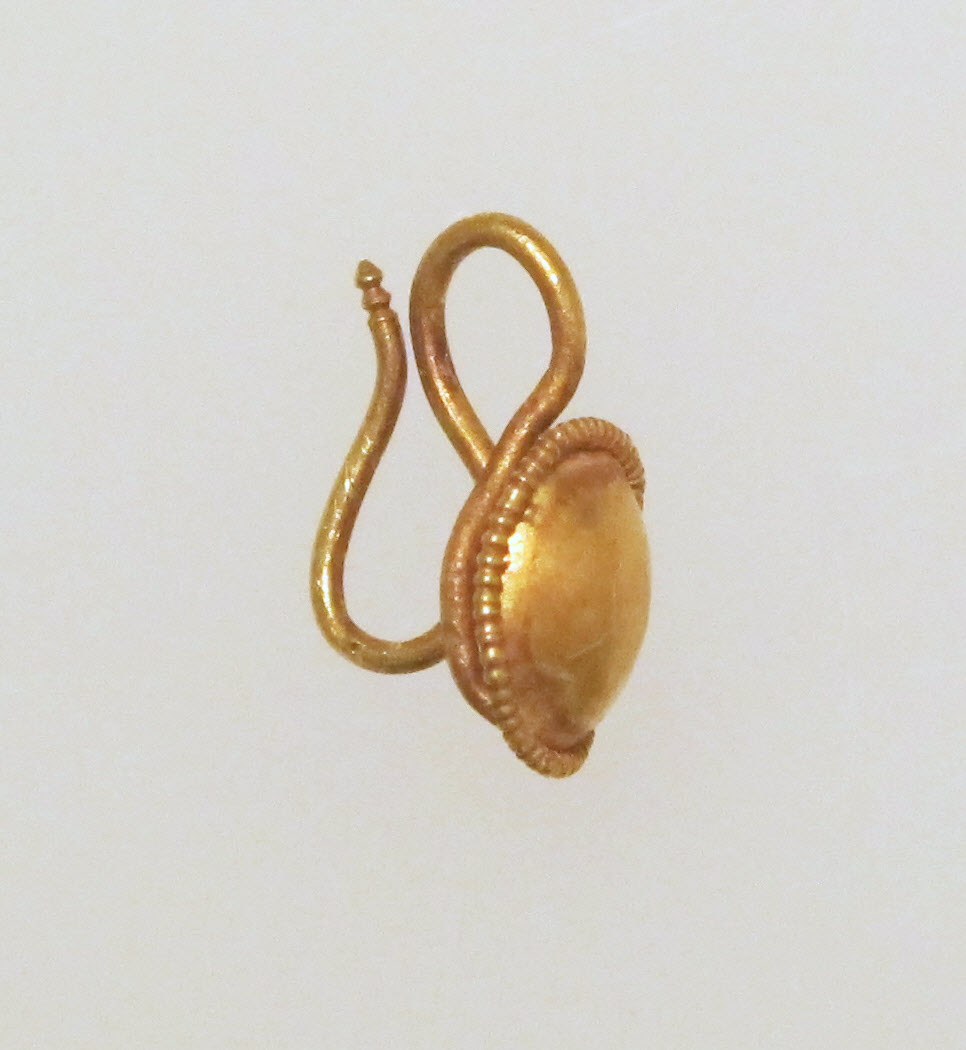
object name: earring hook type with disc and beaded rim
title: Earring-hook type with disc and beaded rim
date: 7000 BCE-330 CE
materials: gold